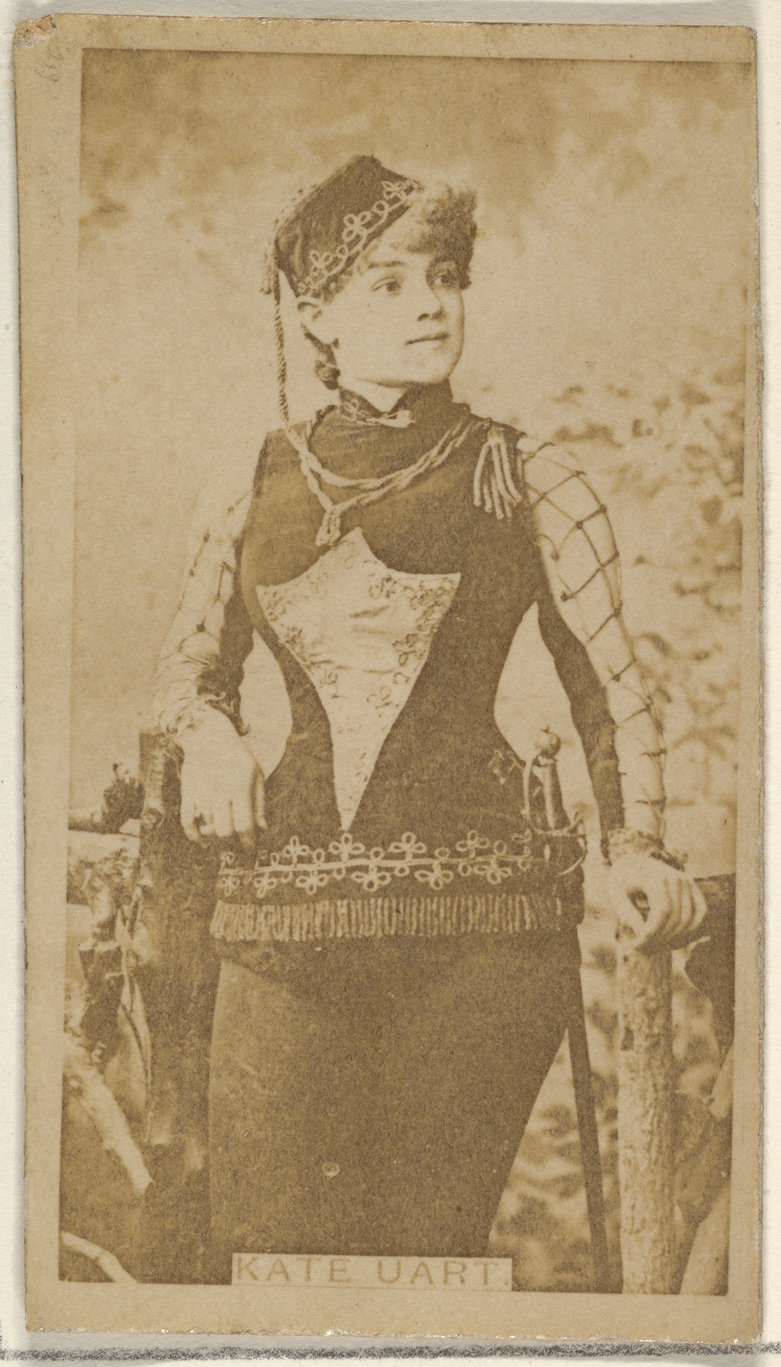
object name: photograph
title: Kate Uart, from the Actors and Actresses series (N45, Type 8) for Virginia Brights Cigarettes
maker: allen & ginter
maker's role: publisher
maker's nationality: american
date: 1888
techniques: albumen silver print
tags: portraits,women,actresses